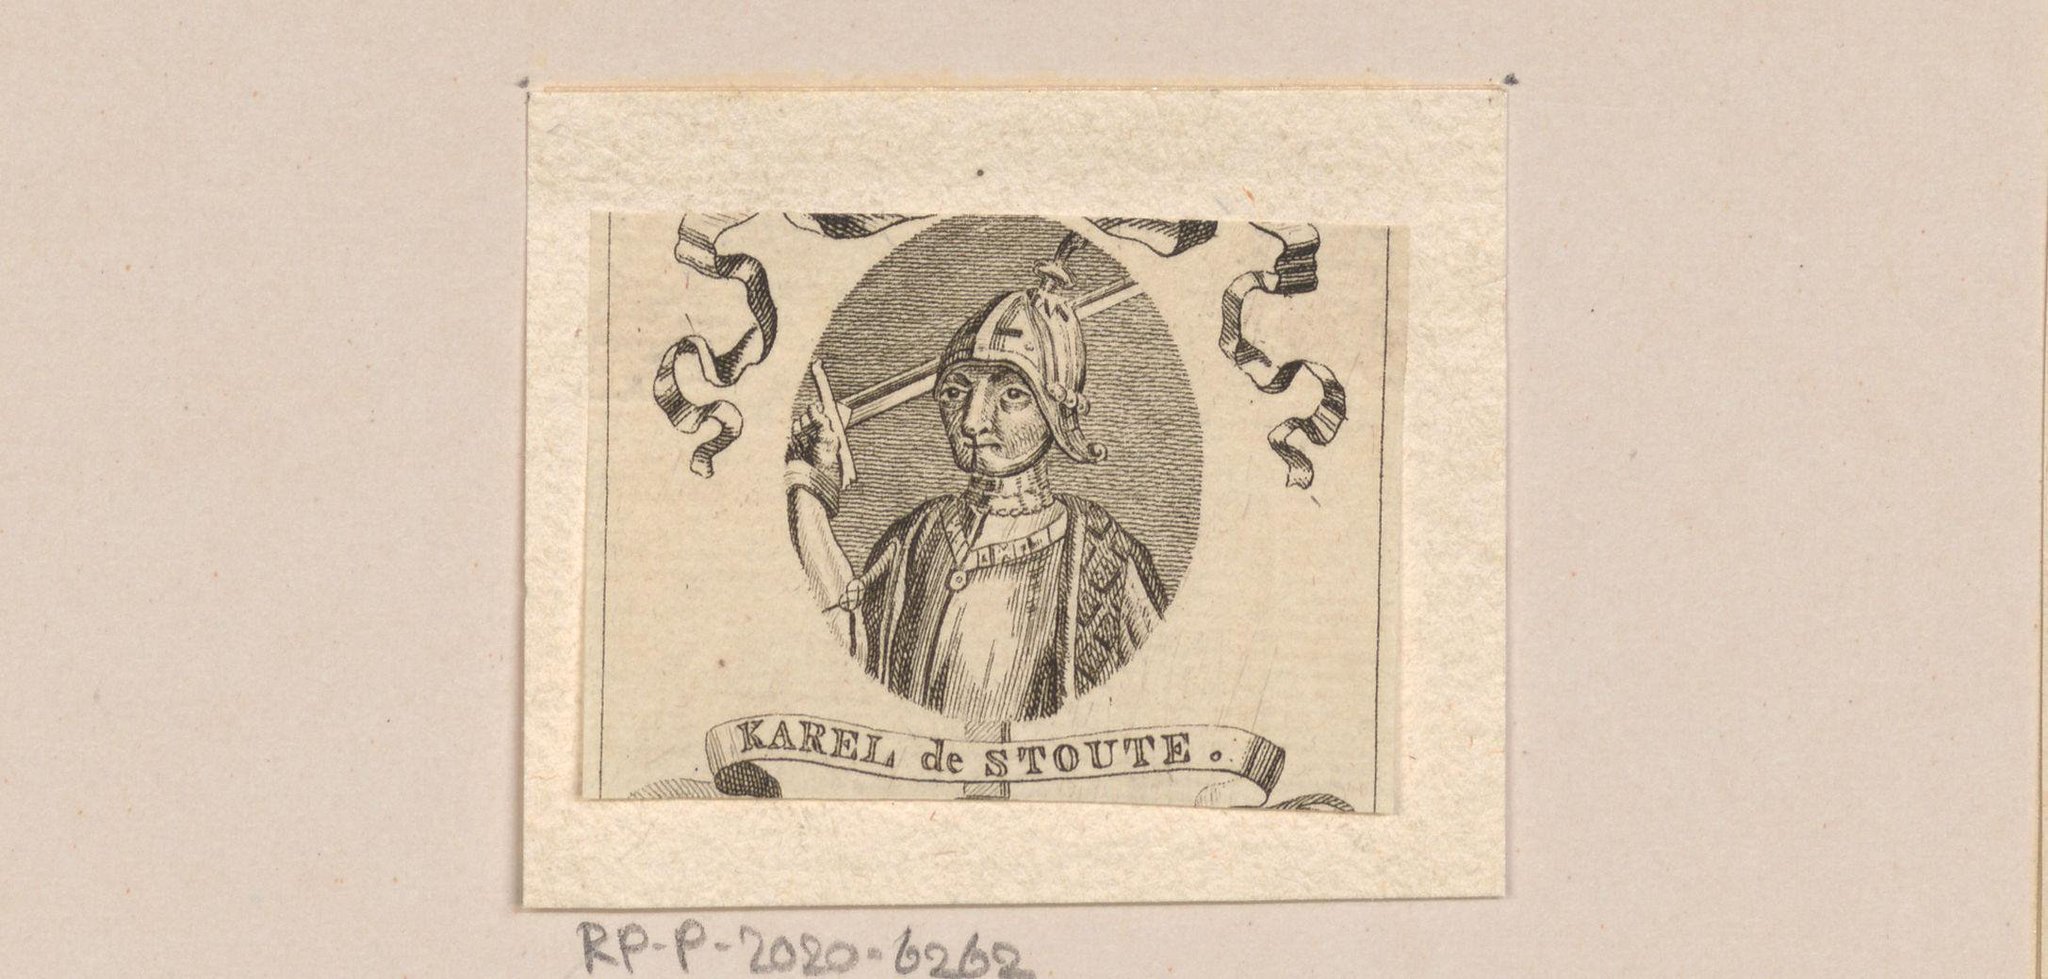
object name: print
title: Portret van Karel de Stoute, hertog van Bourgondië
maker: Anonymous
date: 1650-1749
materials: paper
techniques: etching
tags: earl, charles the bold (duke of burgundy), historical persons